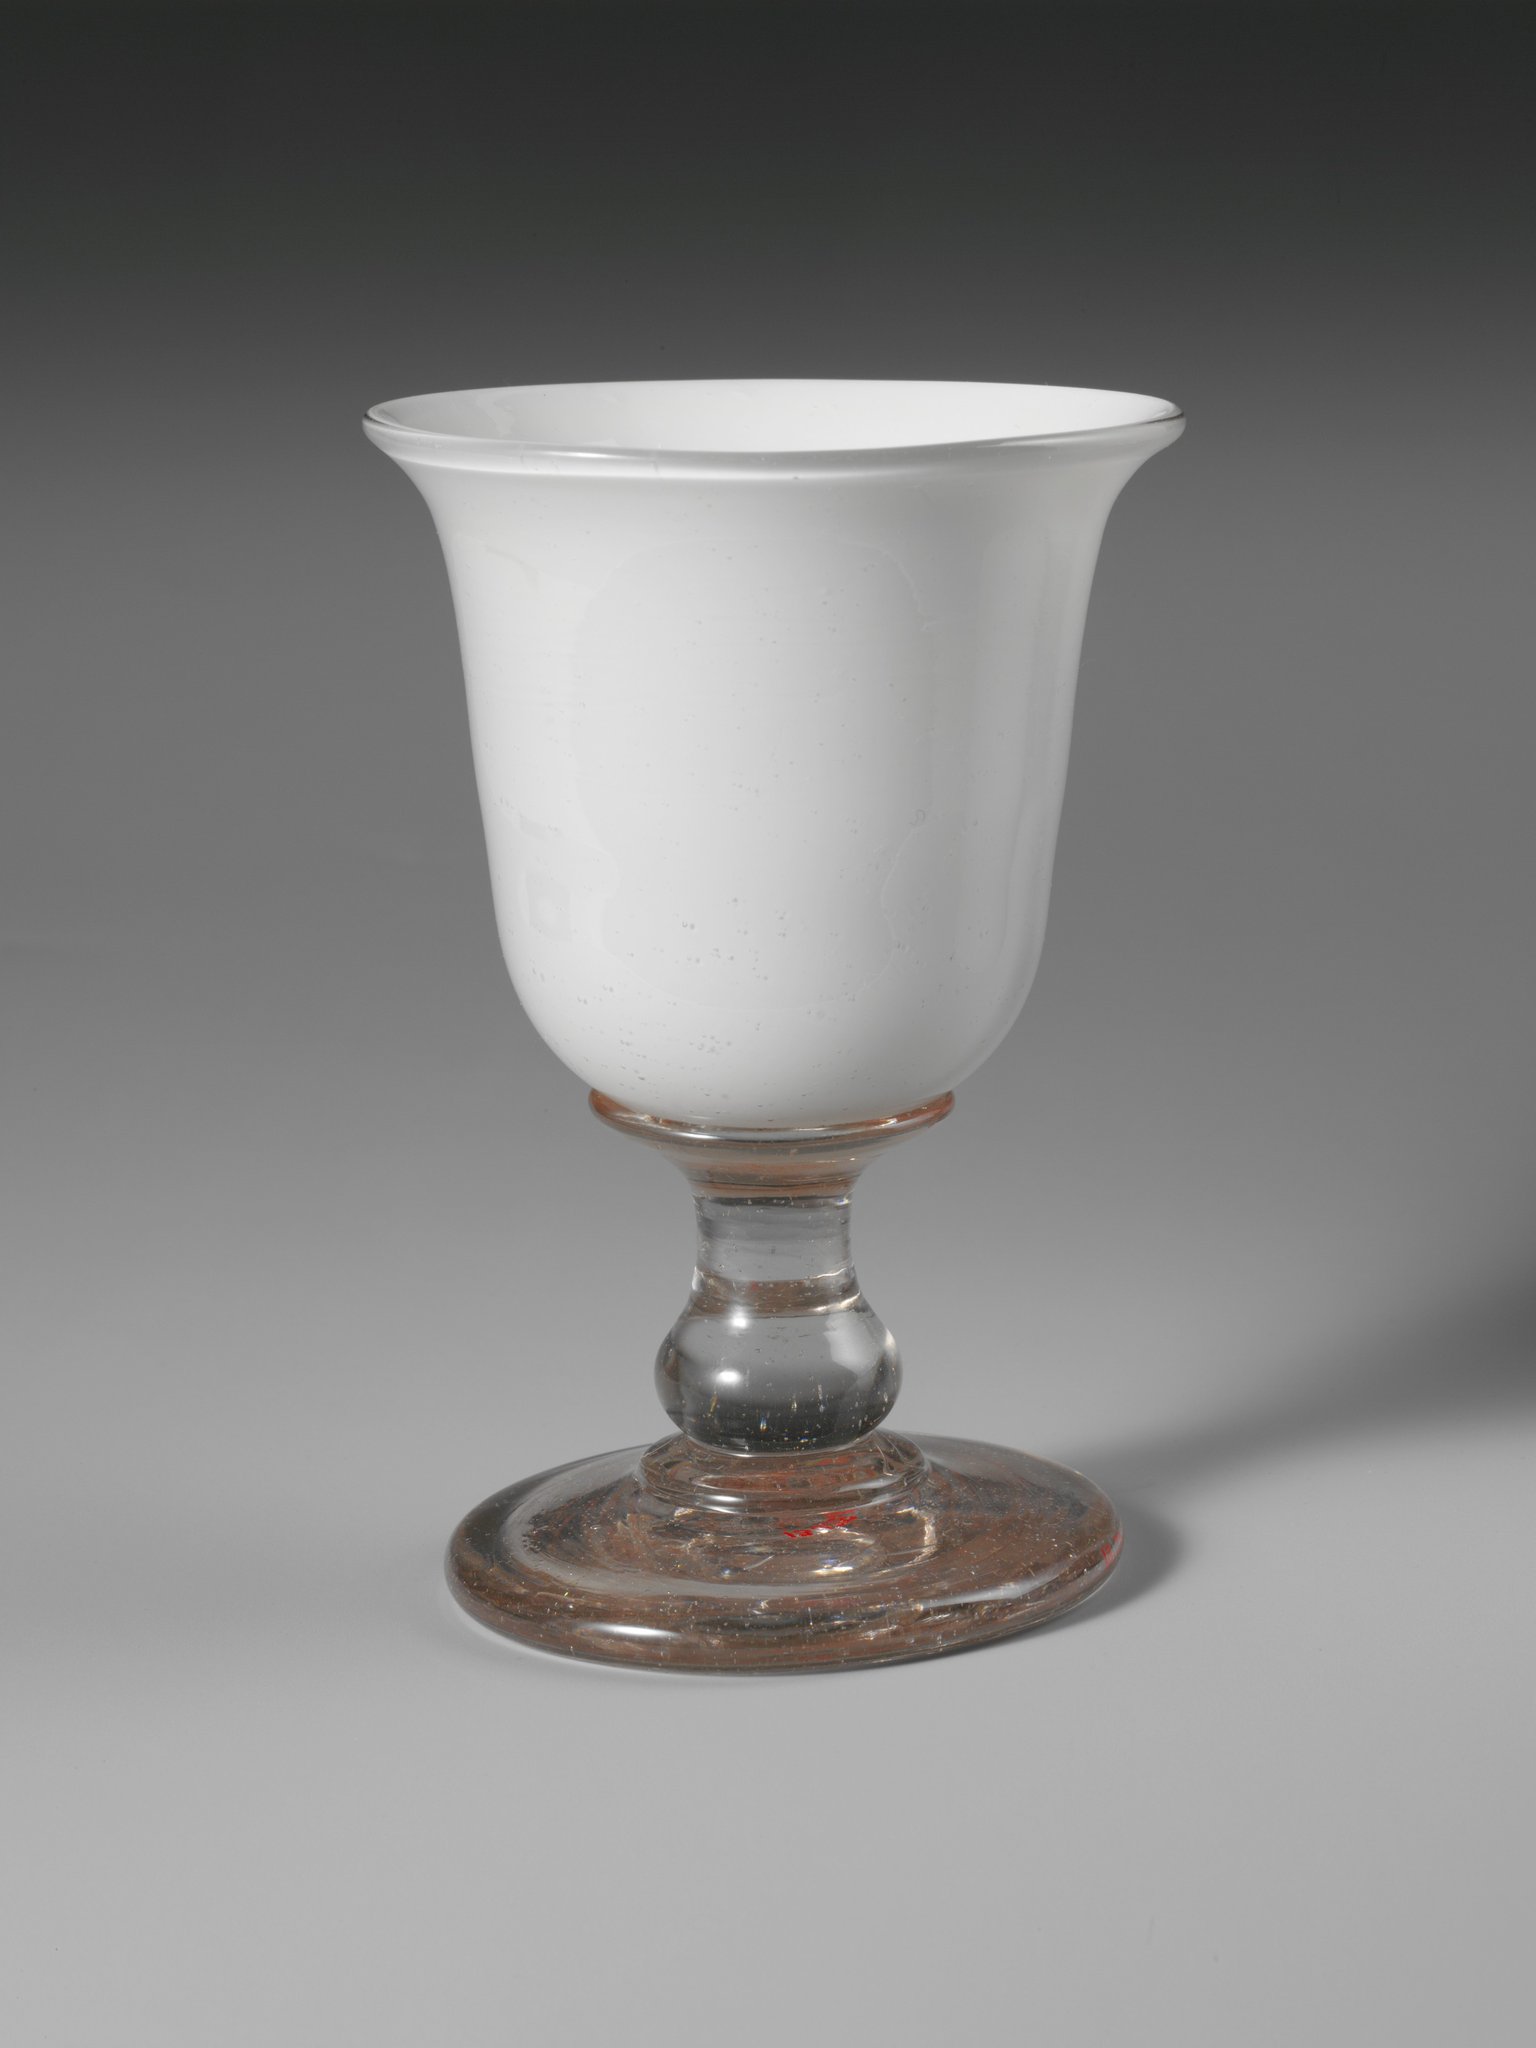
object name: communion cup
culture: american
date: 1830-1870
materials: glass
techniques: glassblowing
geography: united states